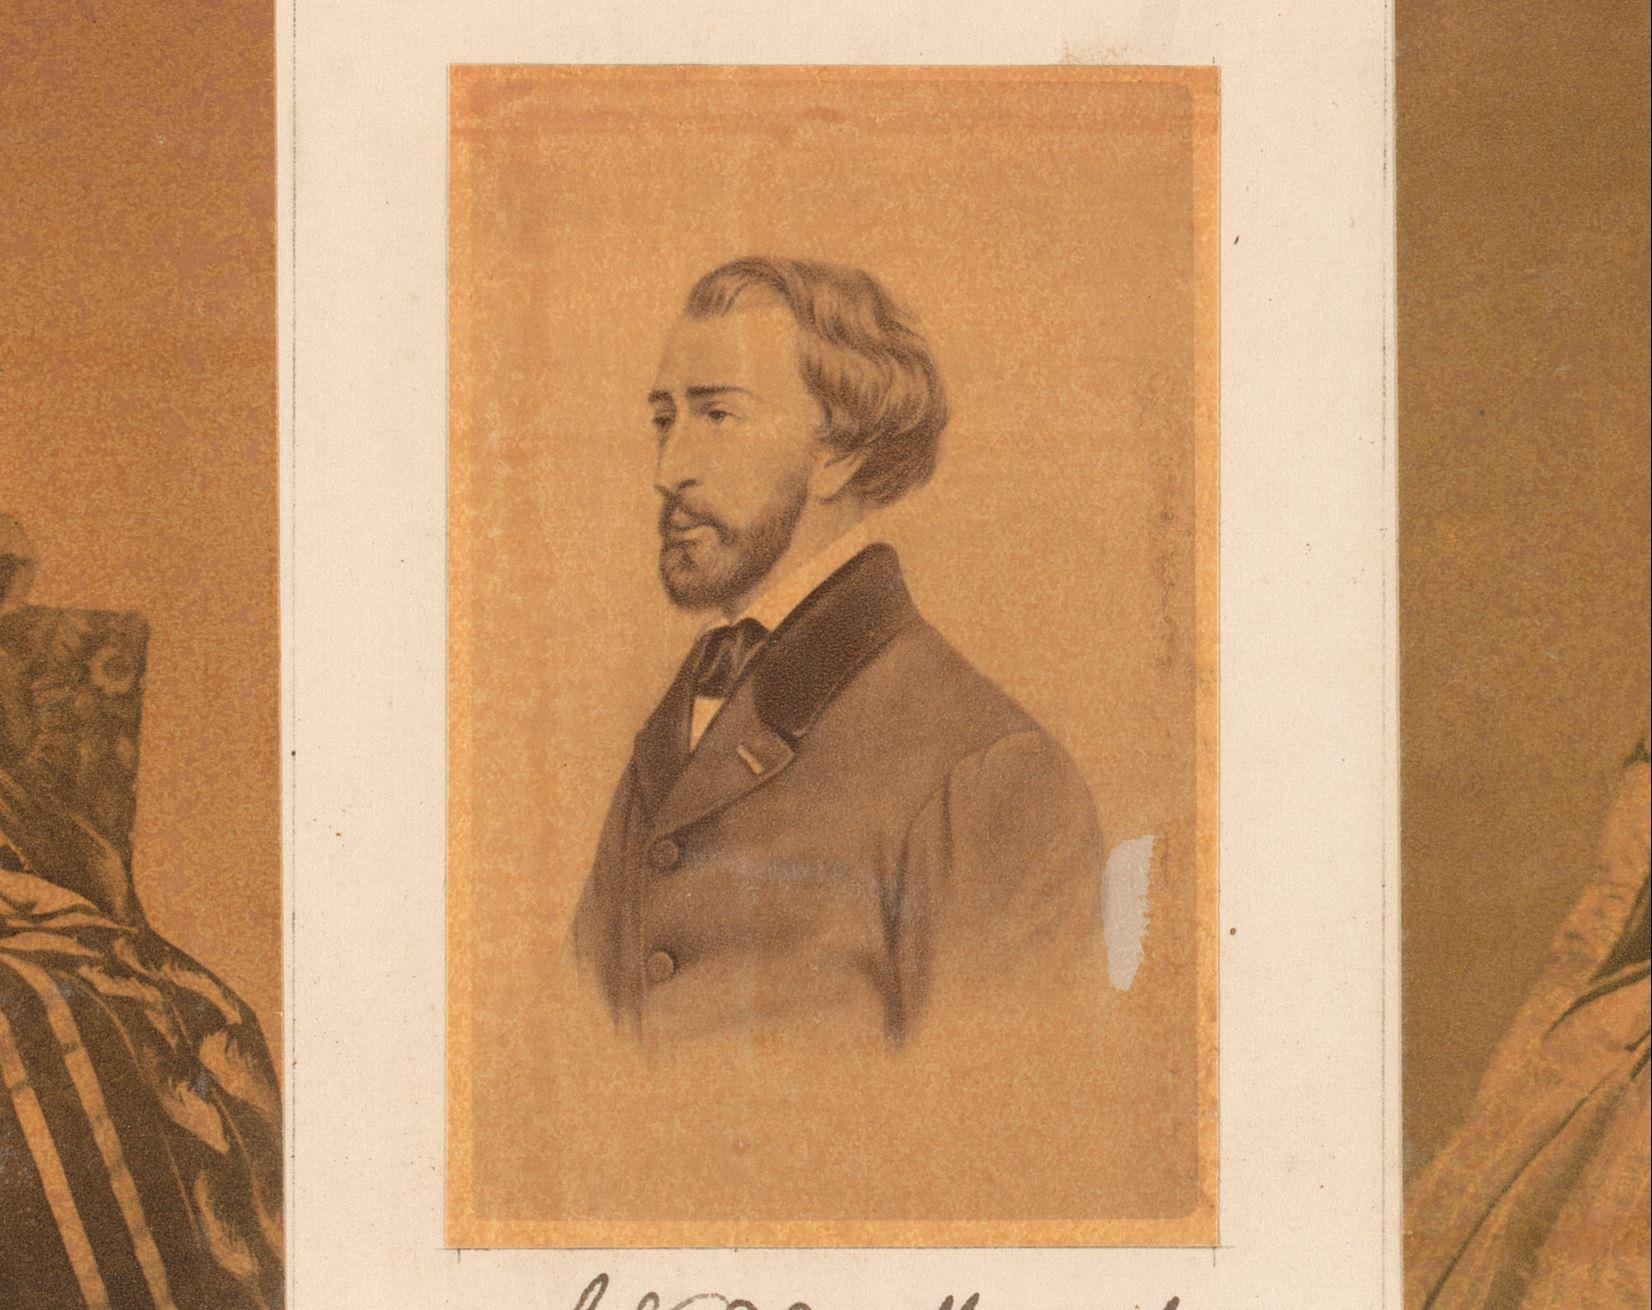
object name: photomechanical print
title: Alfred de Musset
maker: Anonymous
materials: paper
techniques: rotogravure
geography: france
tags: paris, alfred de musset, portrait of a writer, france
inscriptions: inscription: ‘Votre bonne foi d été surprise,/ Grand-père, ce n'est pas un/ portrait d'après nature.’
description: Deze prent maakt deel uit van een album.